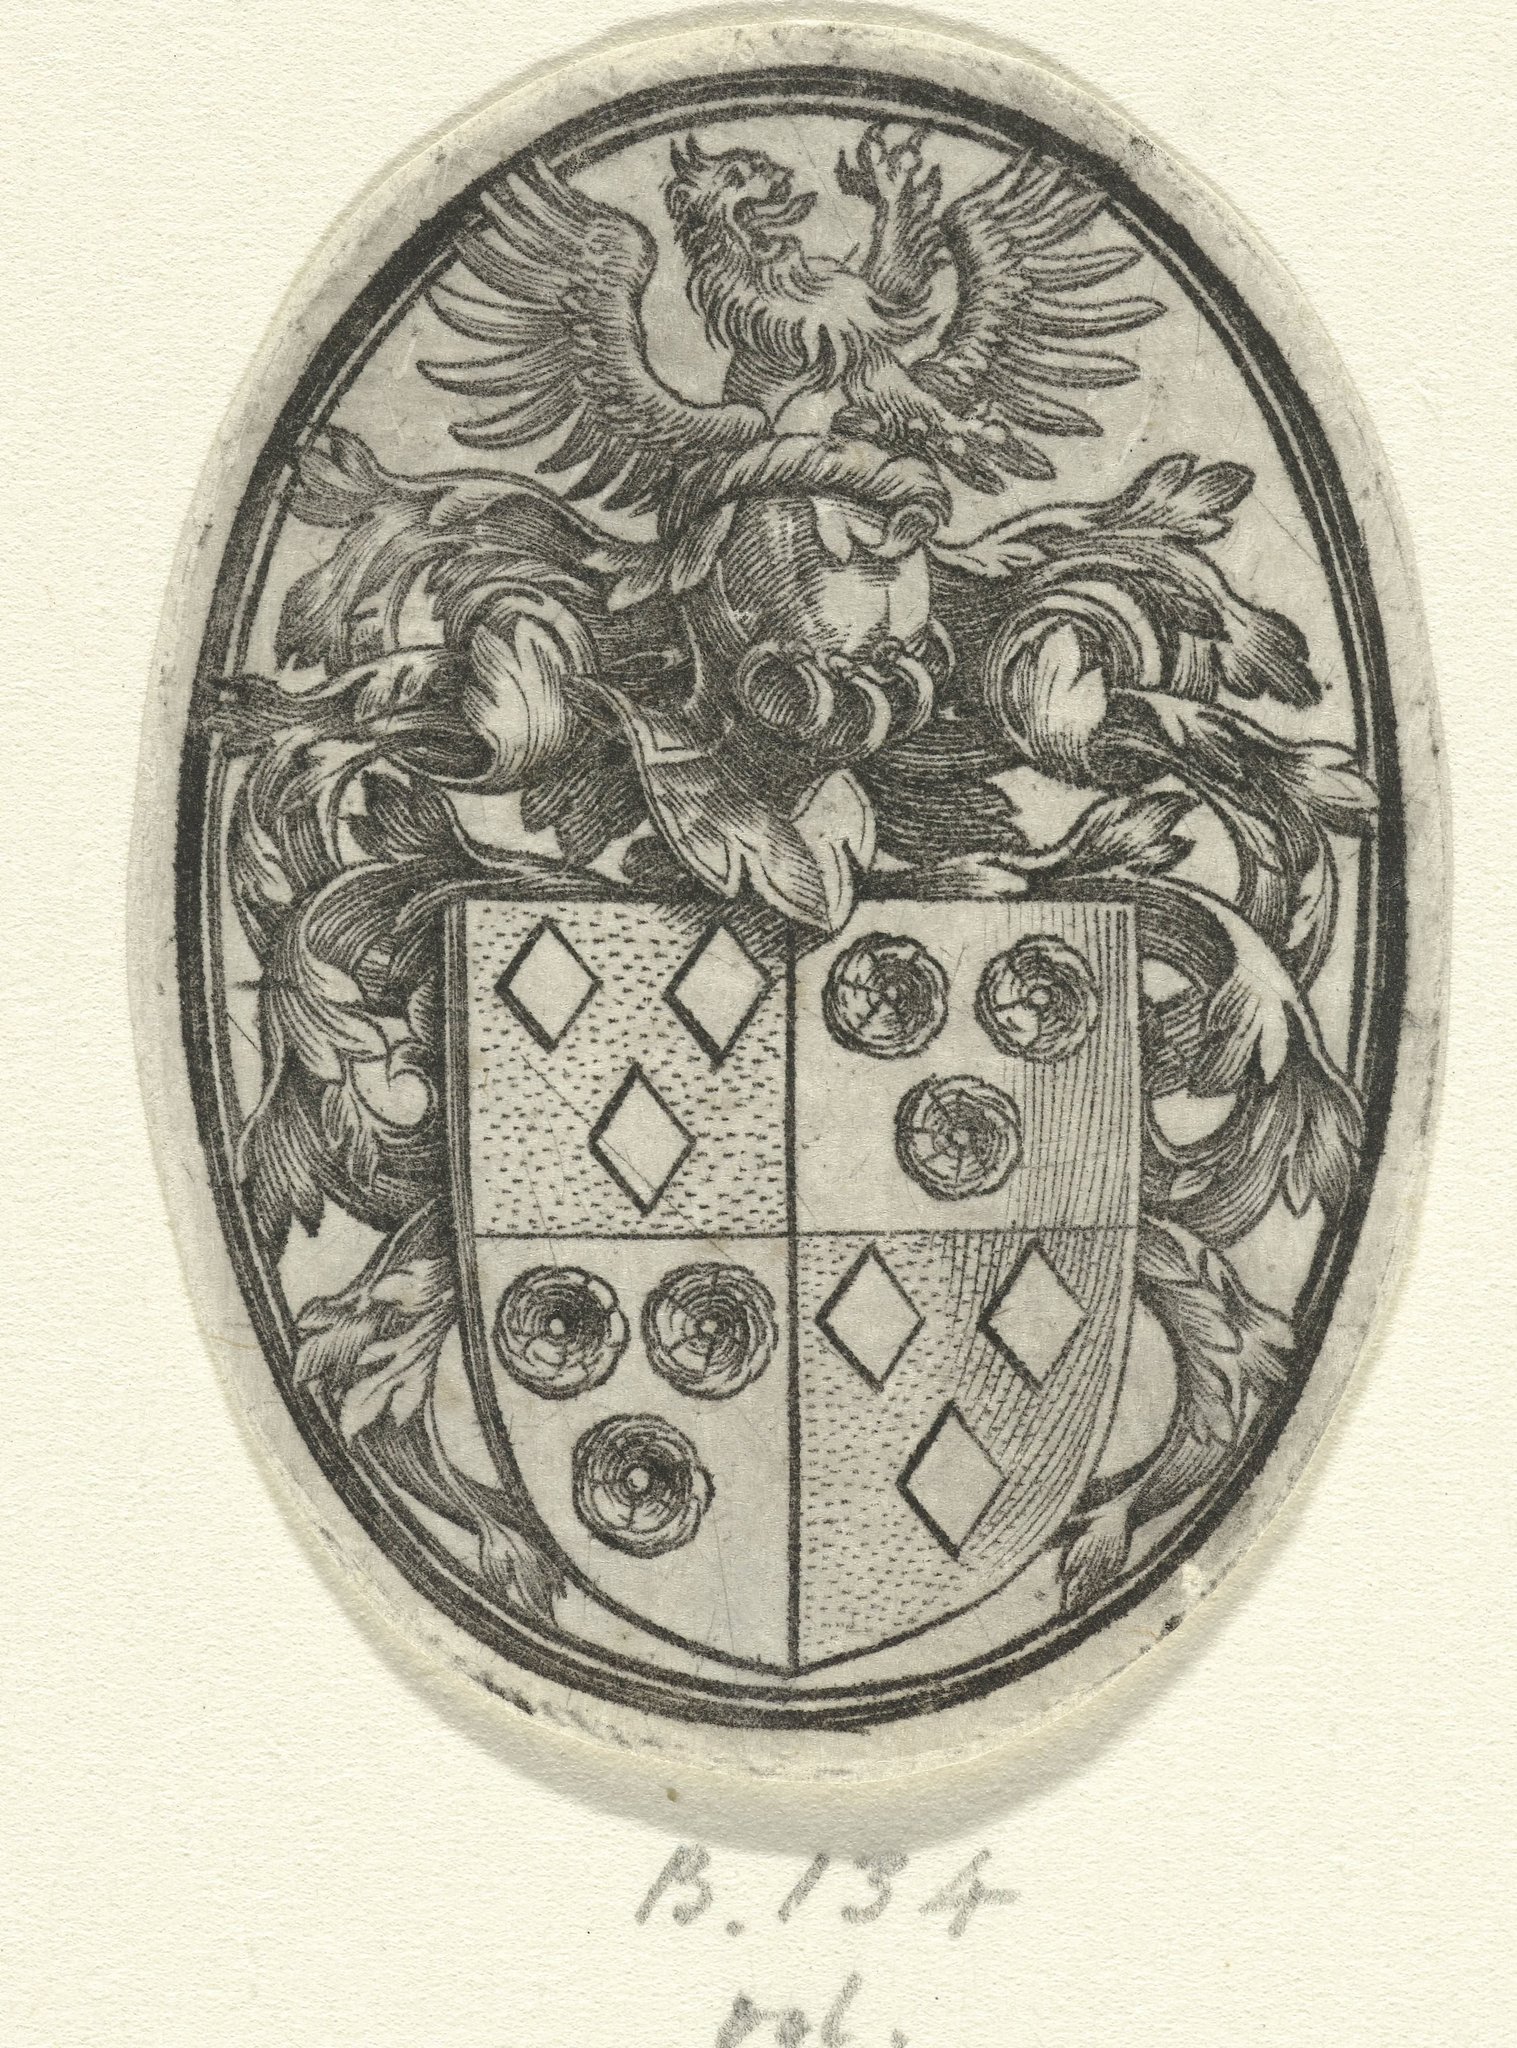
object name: print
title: Wapen van de familie Van Heussen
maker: hendrick goltzius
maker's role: draughtsman, painter, print maker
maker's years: 1558-1617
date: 1579-1584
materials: paper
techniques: engraving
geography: haarlem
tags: armorial bearing, heraldry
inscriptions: collector's mark: Lugt 240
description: Familiewapen van de familie Van Heussen uit Haarlem (tweemaal drie ruiten en tweemaal drie rozetten) in ovaal. Behoort bij een portret van Jan van Heussen.